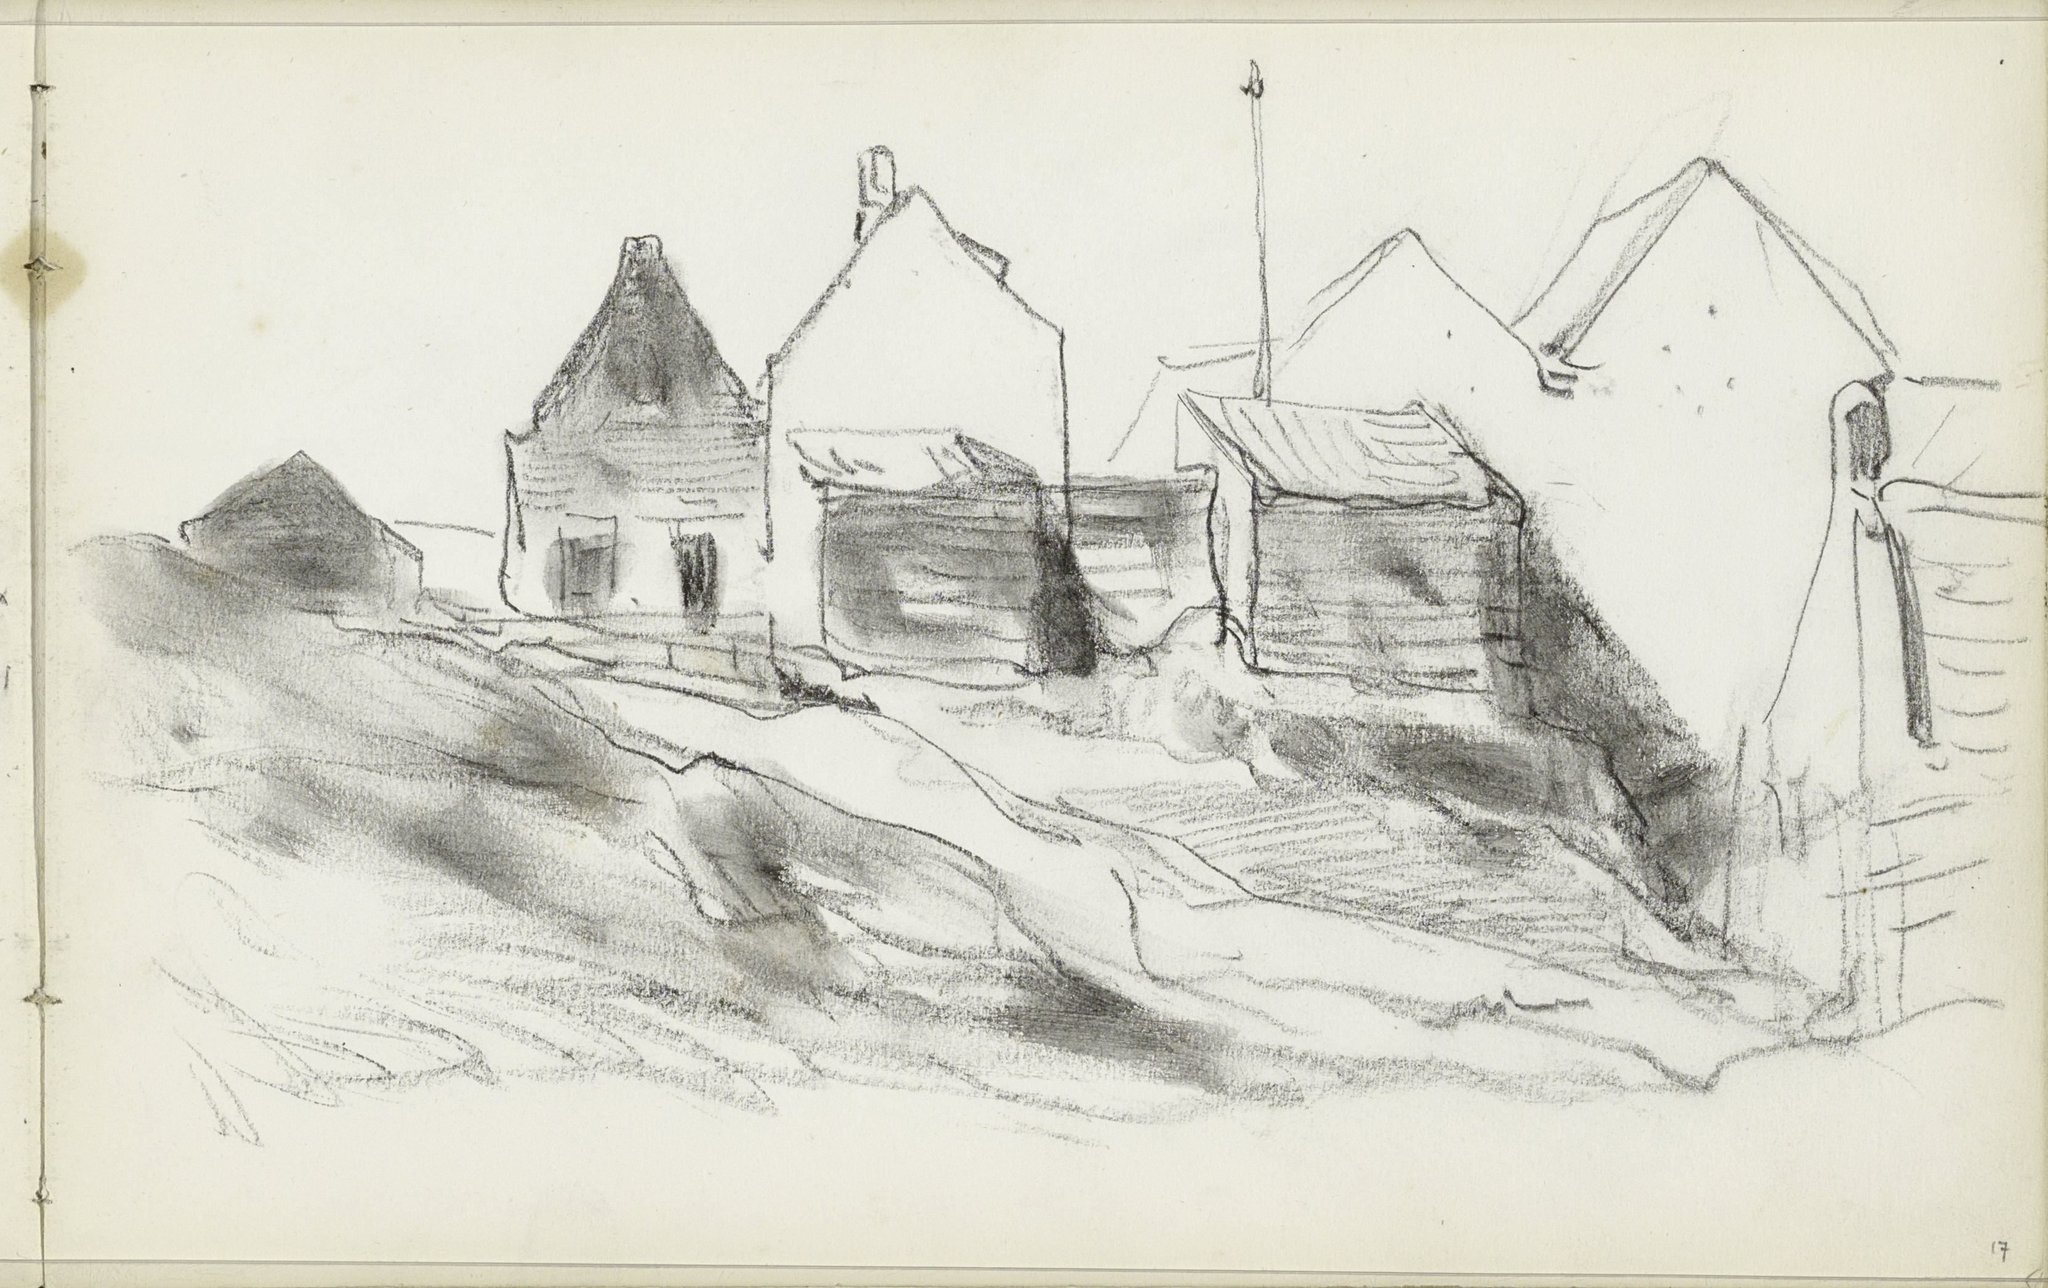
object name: sketchbook leaf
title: Huizen op het duin bij Scheveningen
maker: johannes bosboom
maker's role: draughtsman, painter, print maker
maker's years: 1817-1891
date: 1873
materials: chalk, paper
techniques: brush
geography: scheveningen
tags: dunes (sea not visible); in the dunes, cottage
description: Blad 17 recto uit een schetsboek met 39 bladen.